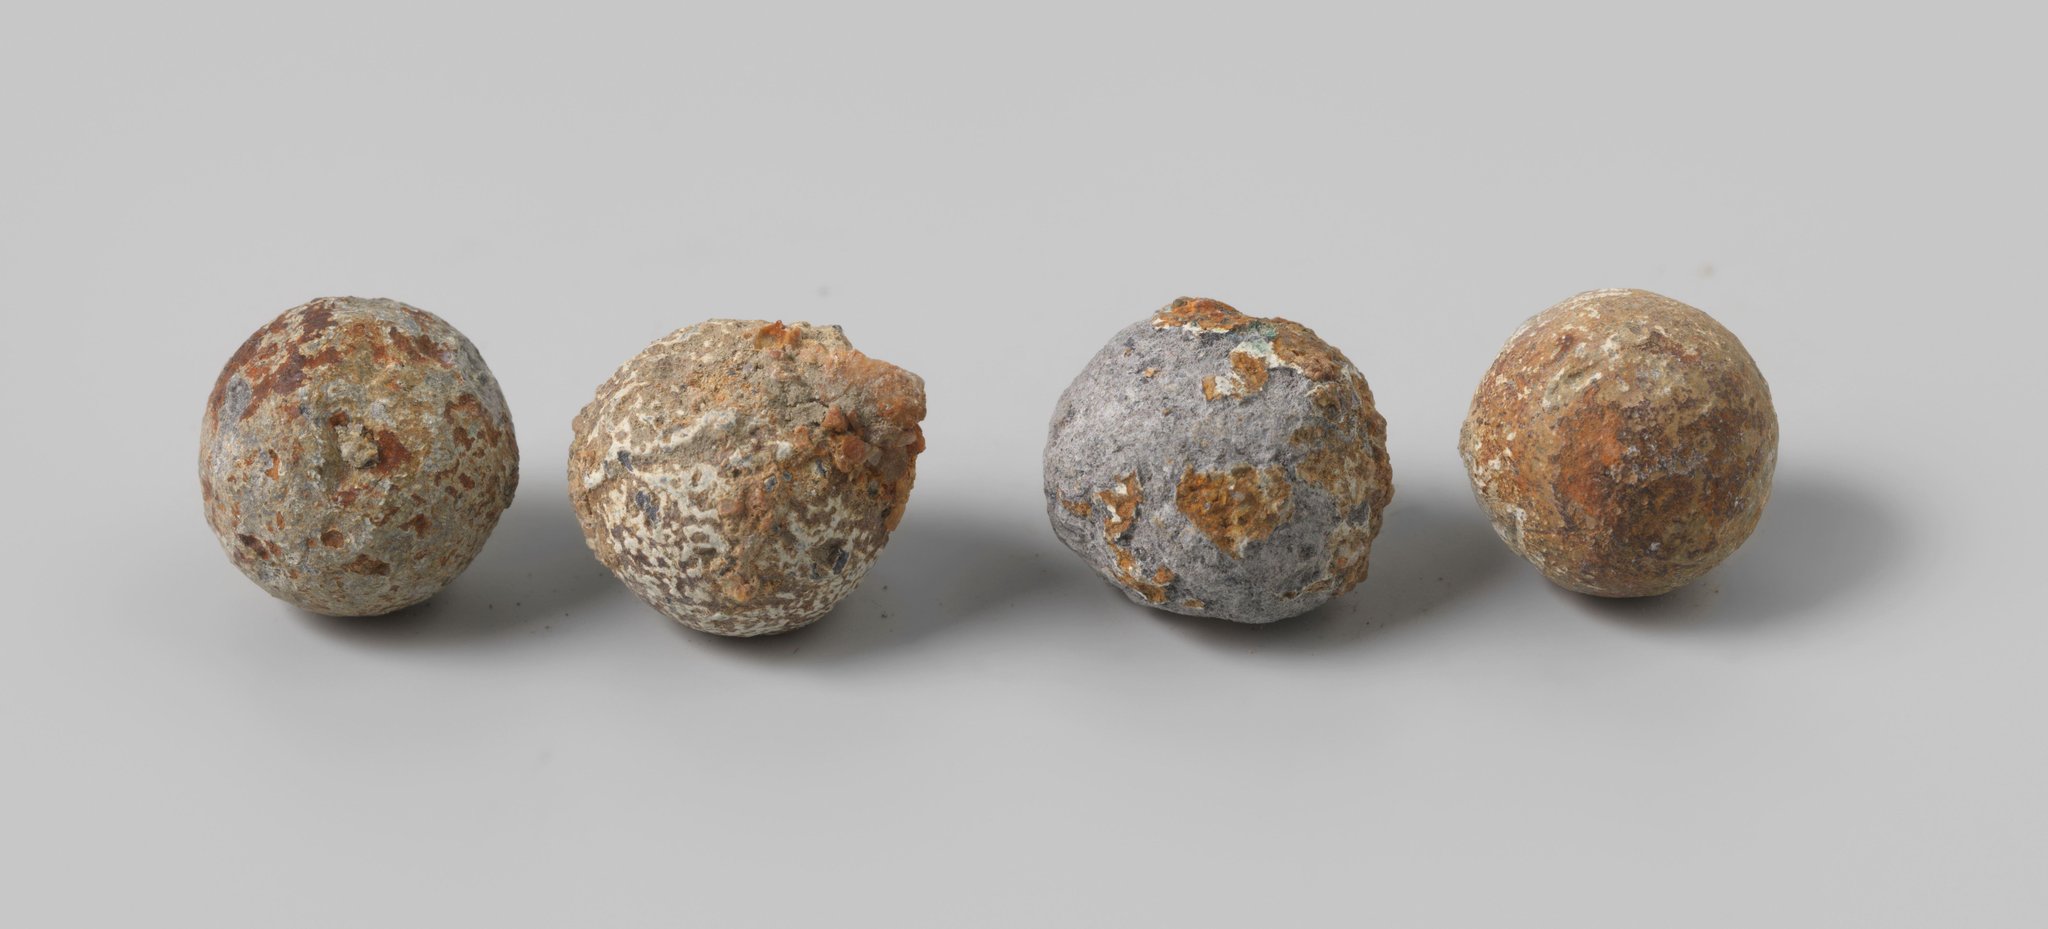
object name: musketkogel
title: Musketkogels uit het wrak van de Oost-Indiëvaarder Hollandia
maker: Anonymous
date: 1700-1743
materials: lead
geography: netherlands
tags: verenigde oostindische compagnie, hollandia (schip), annet